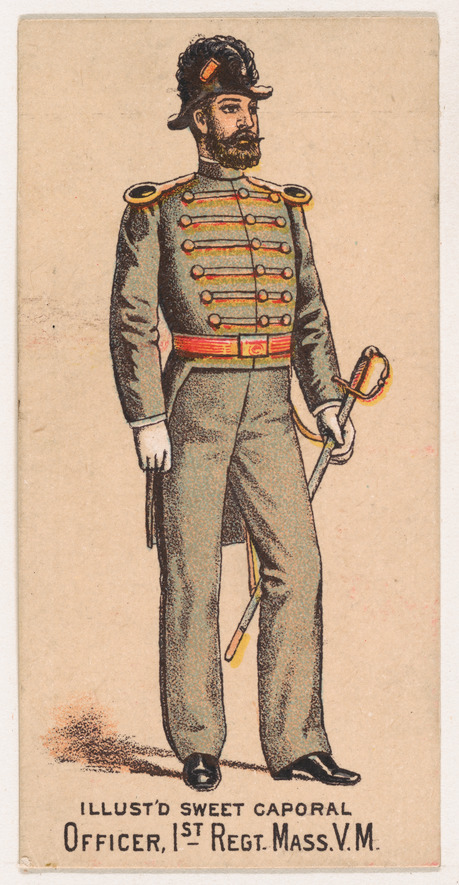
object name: print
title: Officer, 1st Regiment, Massachusetts, V.M., from the Military Series (N224) issued by Kinney Tobacco Company to promote Sweet Caporal Cigarettes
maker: kinney brothers tobacco company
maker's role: publisher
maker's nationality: american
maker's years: 1869-2011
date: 1888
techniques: color lithograph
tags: military,swords,men